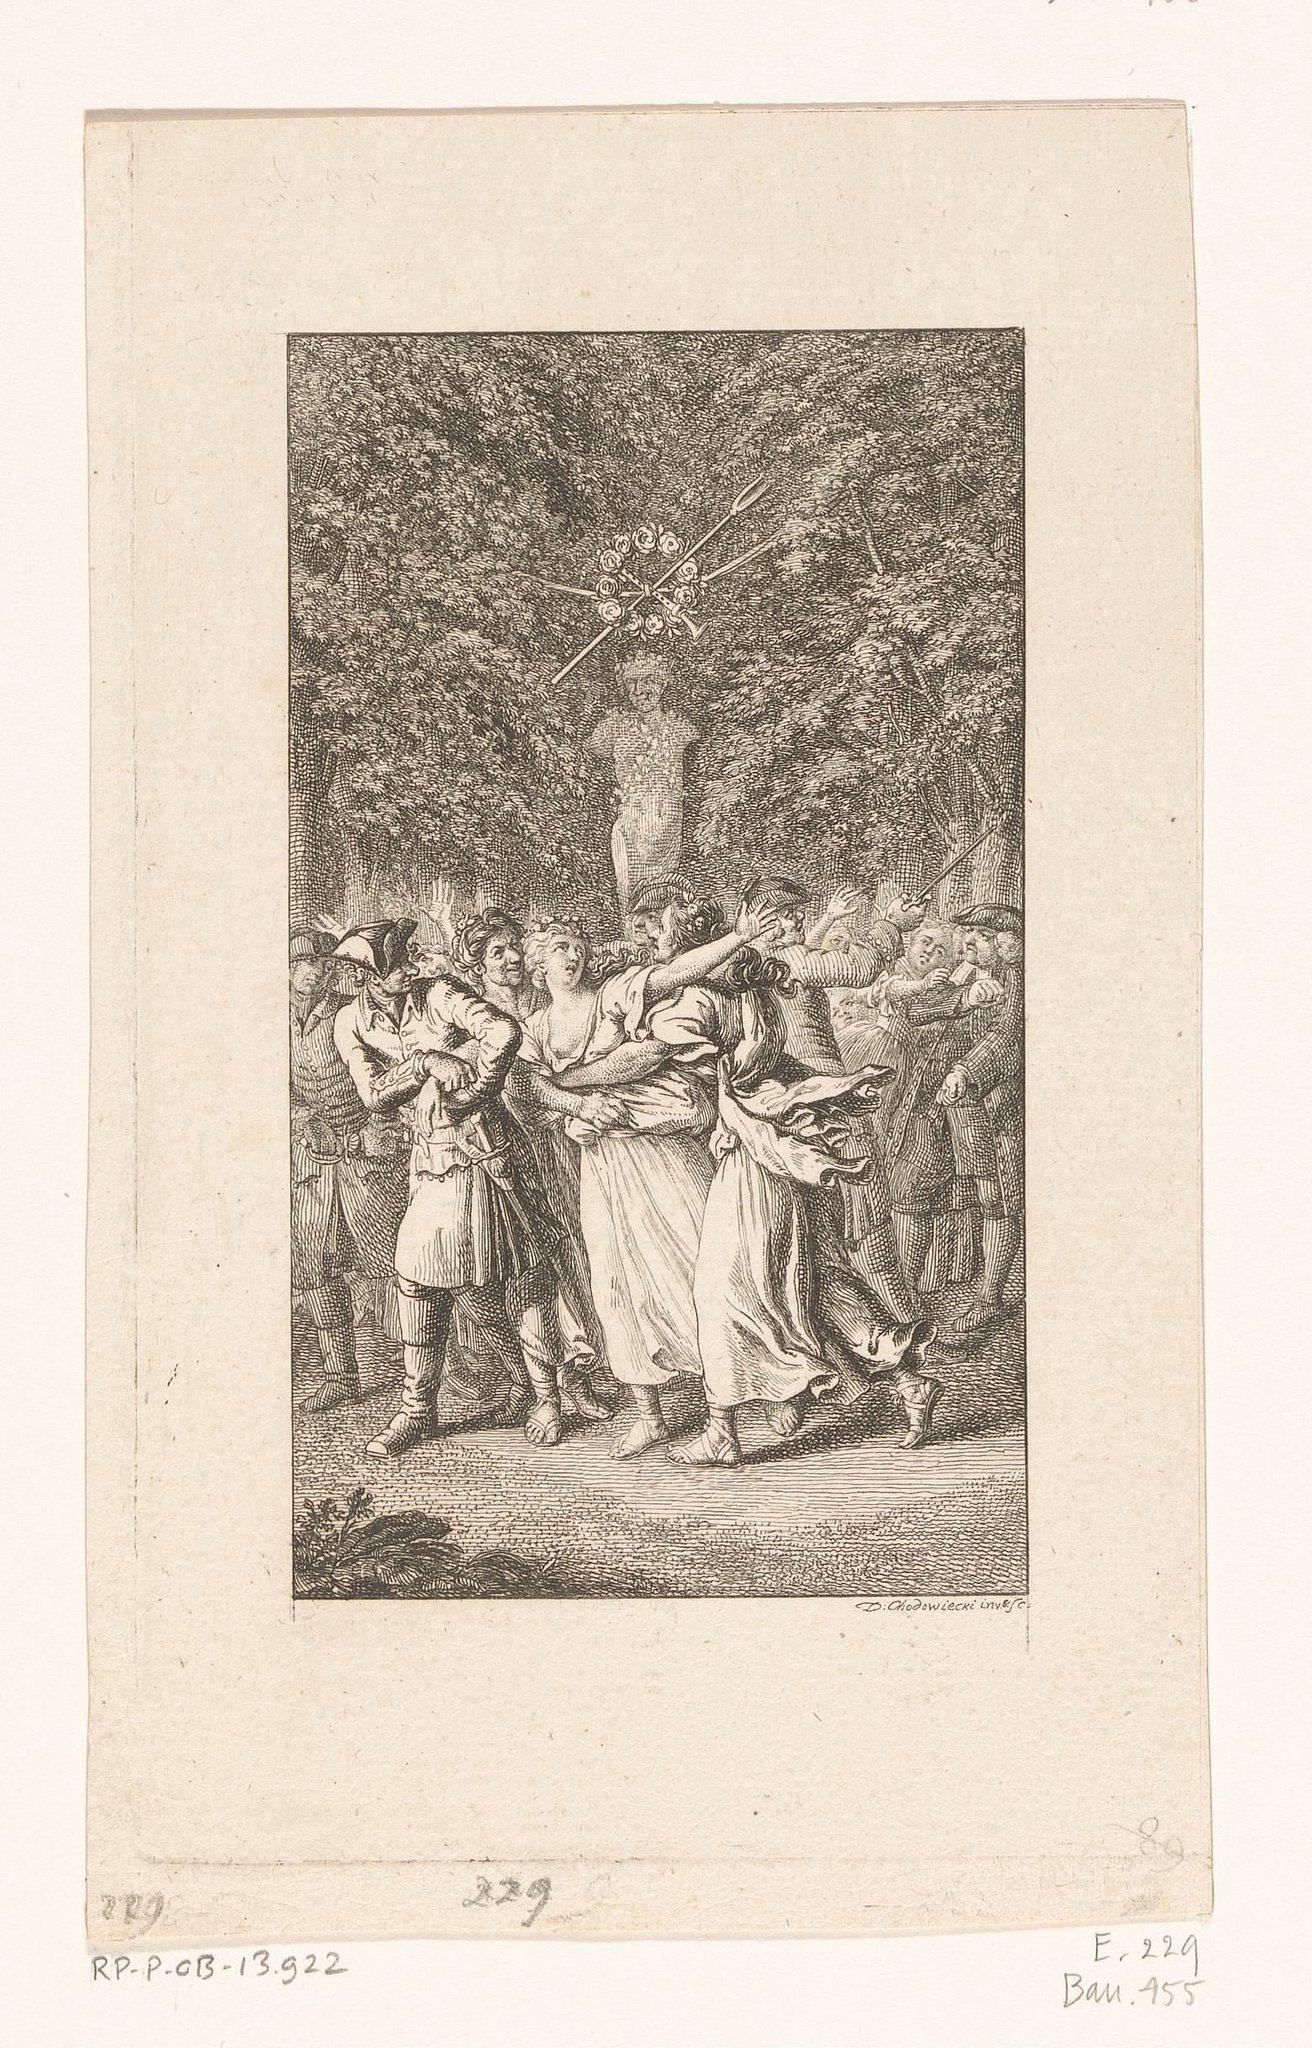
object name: print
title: Miss West wordt ontvoerd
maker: daniel nikolaus chodowiecki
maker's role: draughtsman, print maker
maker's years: 1726-1801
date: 1778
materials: paper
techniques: etching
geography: berlin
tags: theatre, theatrical performance, literature, man abducting woman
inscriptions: collector's mark: Lugt 2228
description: Een latere staat van deze prent is gebruikt in: Leben, Bemerkungen und Meinungen Johann Bunkels, nebst den Leben verscheidener merkwürdiger Frauenzimmer. 4 dln. Berlijn: Friedrich Nicolai, 1778. De Engelse uitgave verscheen tussen 1756-1766 onder de titel 'The life of John Buncle' en wordt meestal toegeschreven aan Thomas Armory. Chodowiecki etste in totaal 16 scènes voor dit werk.